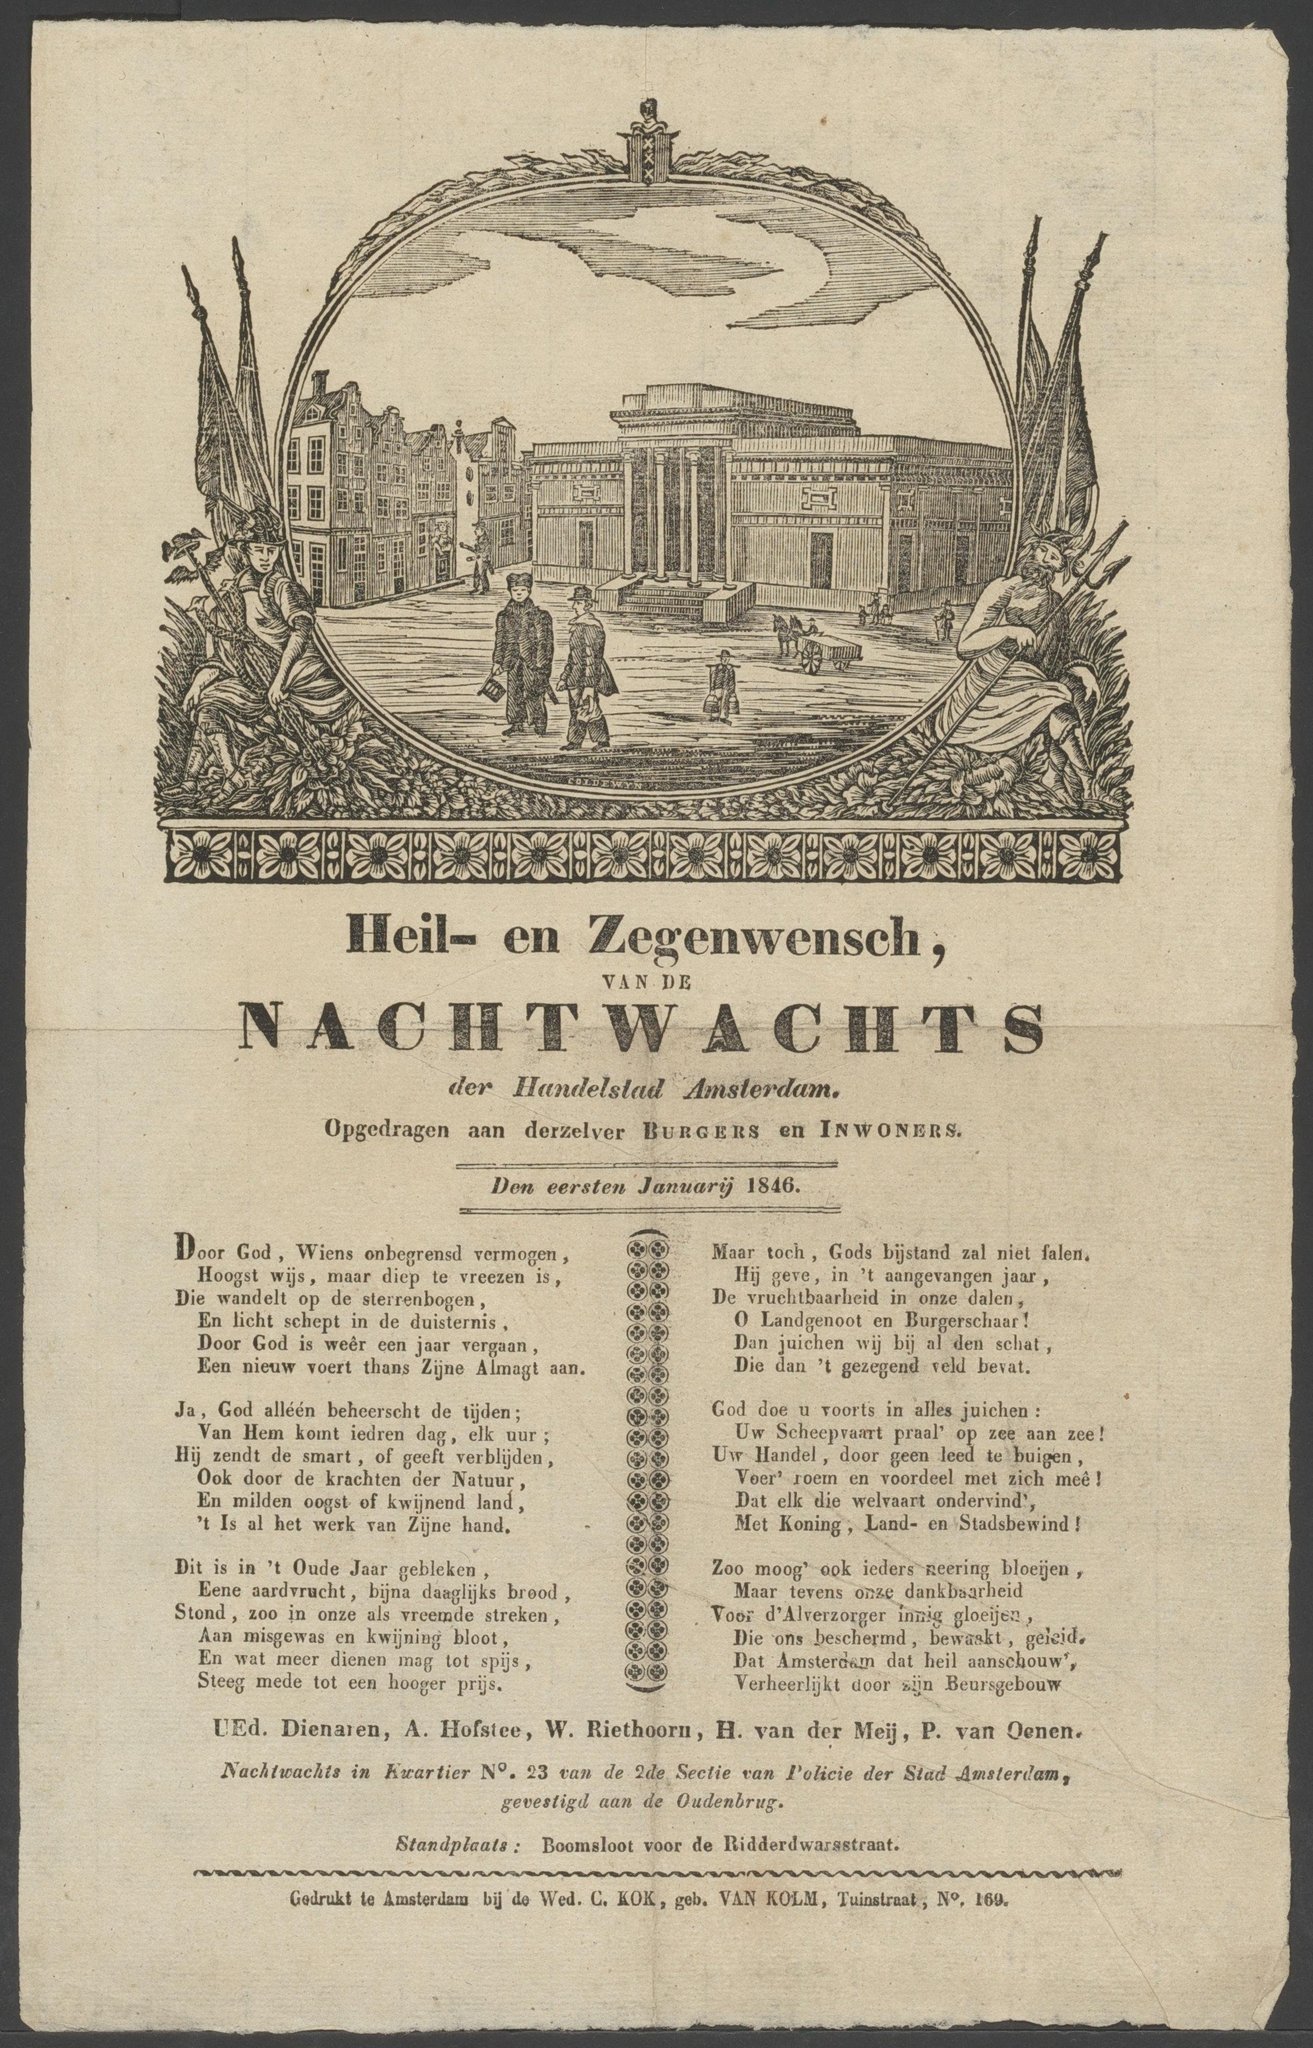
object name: new year card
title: Heil- en Zegenwensch, Nachtwachts der Handelstad Amsterdam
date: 1845-1846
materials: paper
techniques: letterpress printing, engraving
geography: amsterdam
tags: night patrol, stock exchange, stock-market, river-gods, freedom, liberty; 'libertà' (ripa), amsterdam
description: Nieuwjaarswens van de Amsterdamse nachtwacht (ratelwacht) voor het jaar 1846. Enkele mannen lopen 's nachts met ratels door een straat voor de Beurs van Zocher. Ovale voorstelling met links de Vrijheid en rechts een riviergod. Met een vers in twee kolommen. Namens de nachtwacht in kwartier No. 23 van de 2e sectie van Politie: A. Hofstee, W. Riethoorn, H. van der Meij en P. van Oenen. Onderwerpsrubrieken binnen de Atlas Zeden en Gewoonten: Zeden en gewoonten in engeren zin, Volksleven, Volksbladen, Nieuwjaars- en Kerstwenschen, Amsterdam.